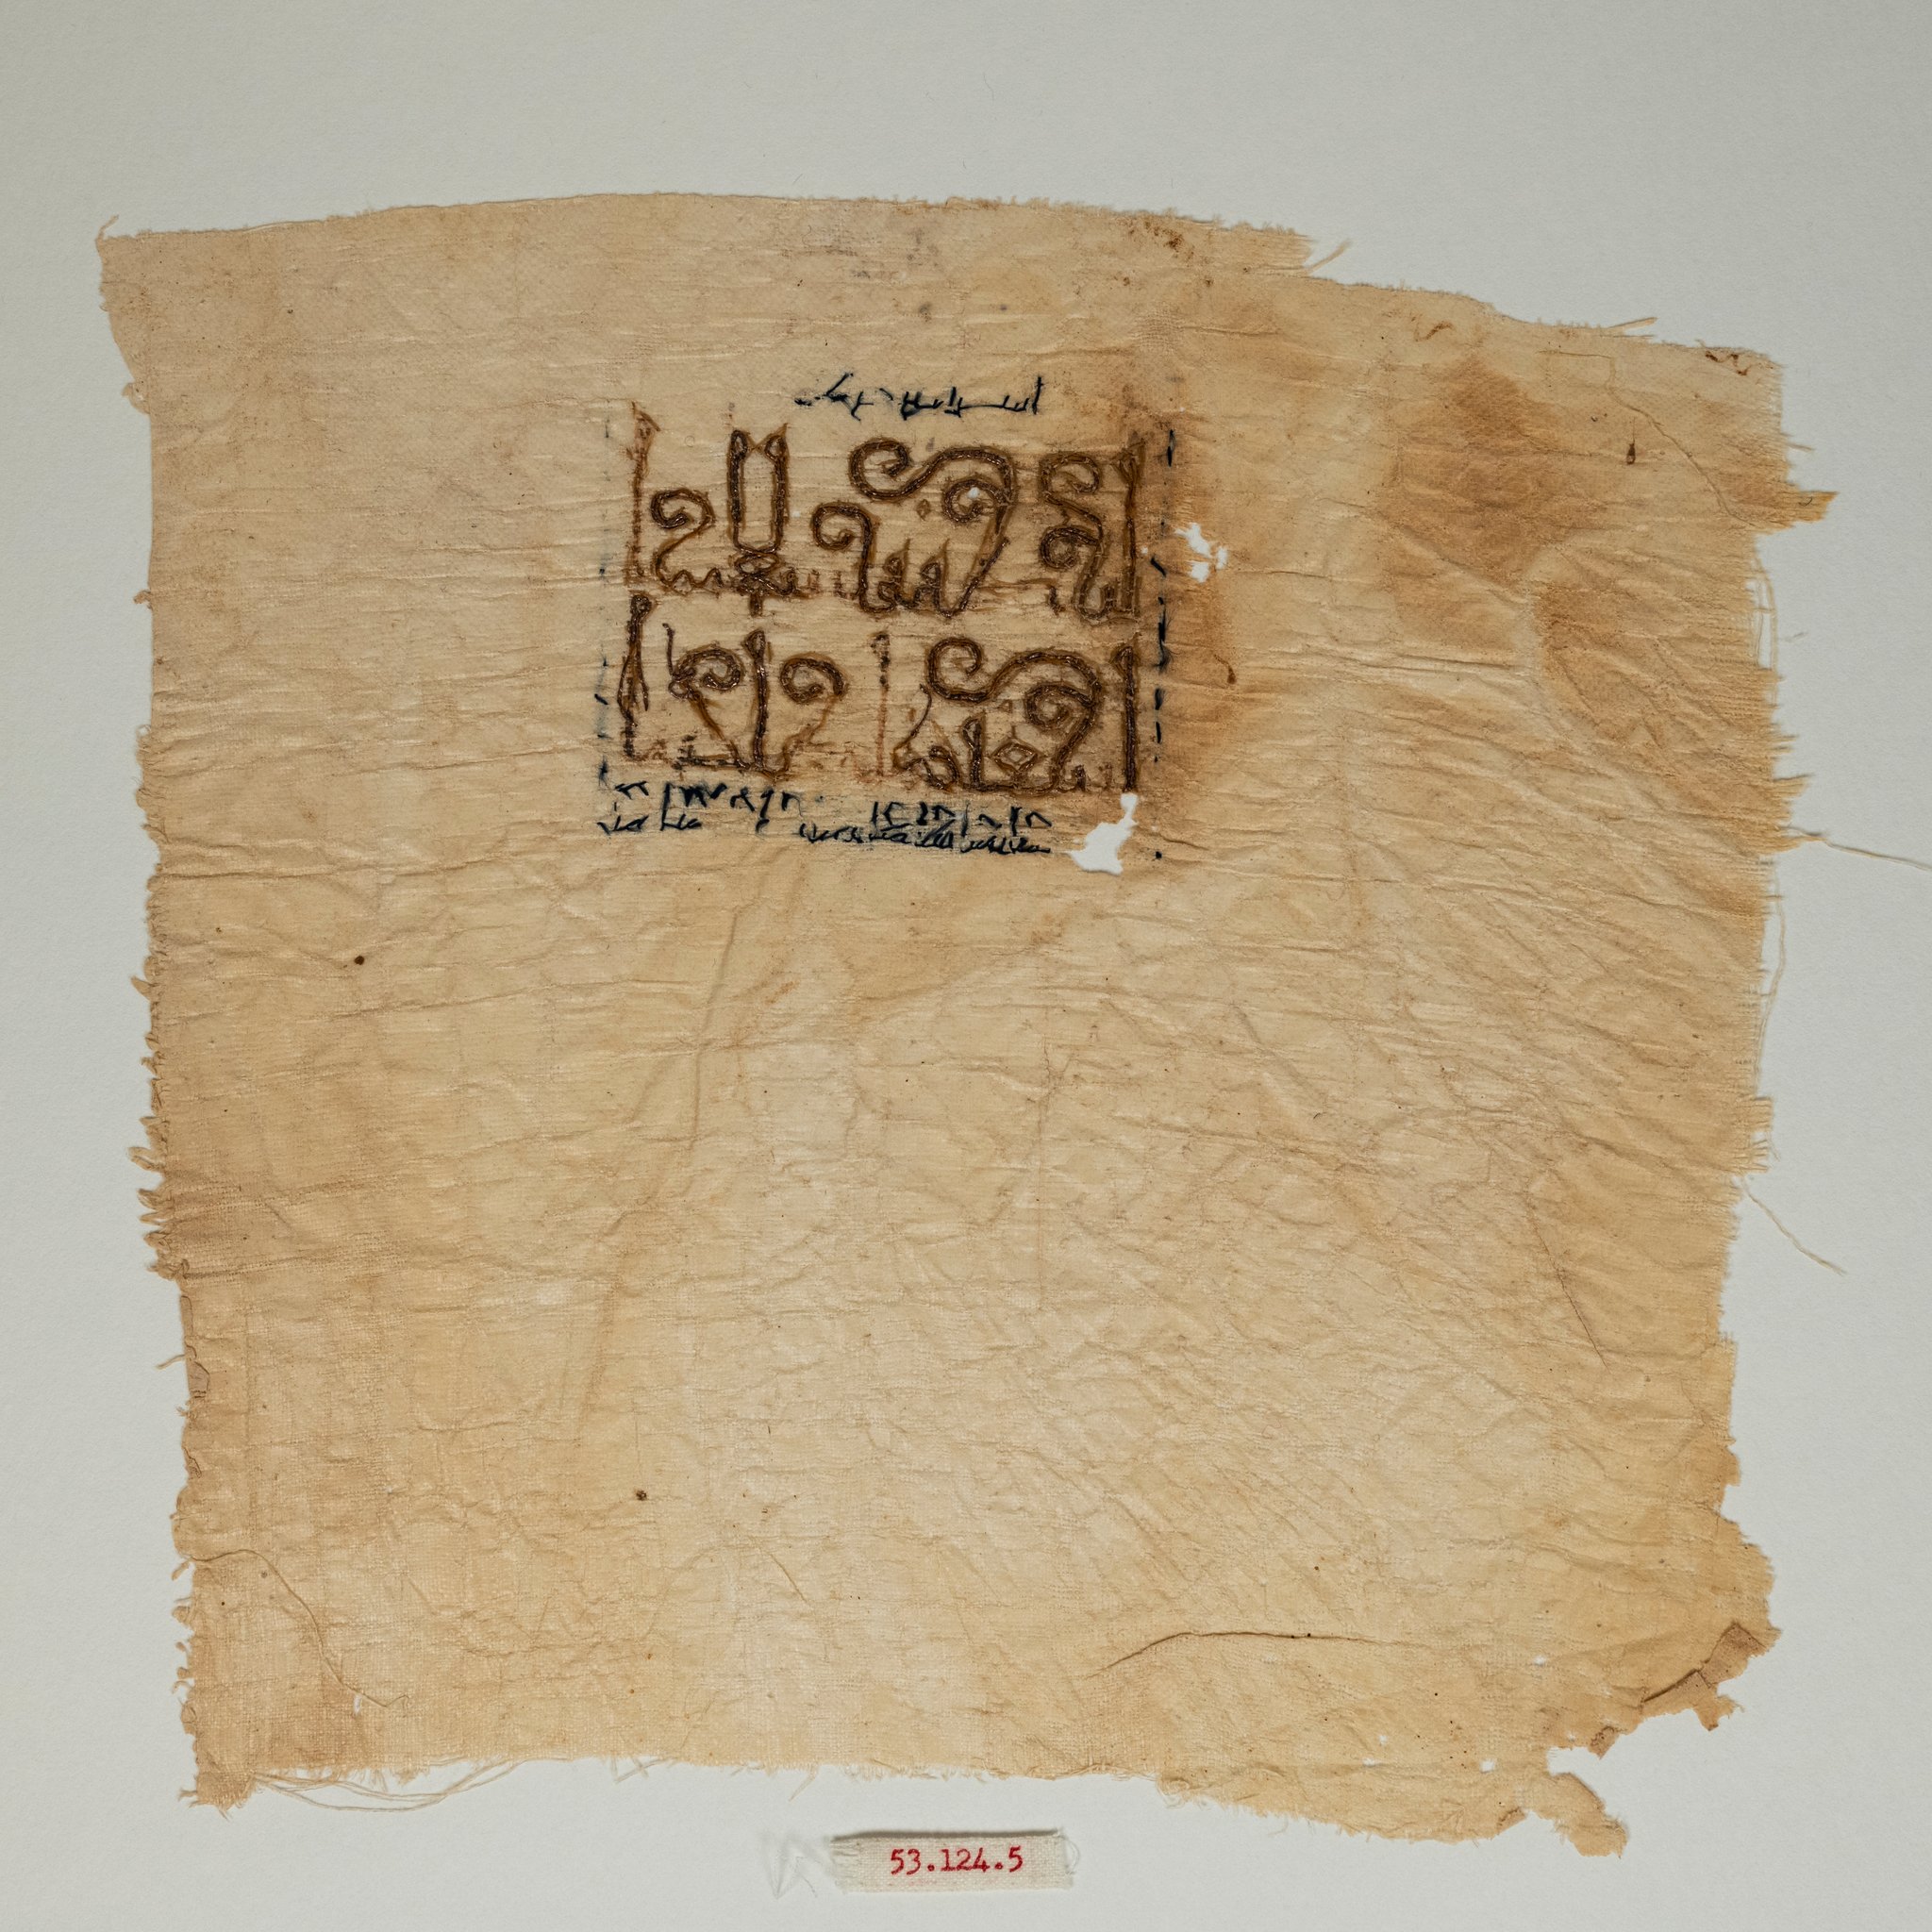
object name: textile fragment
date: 901-1000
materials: gold, linen, silk, thread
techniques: embroidery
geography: egypt